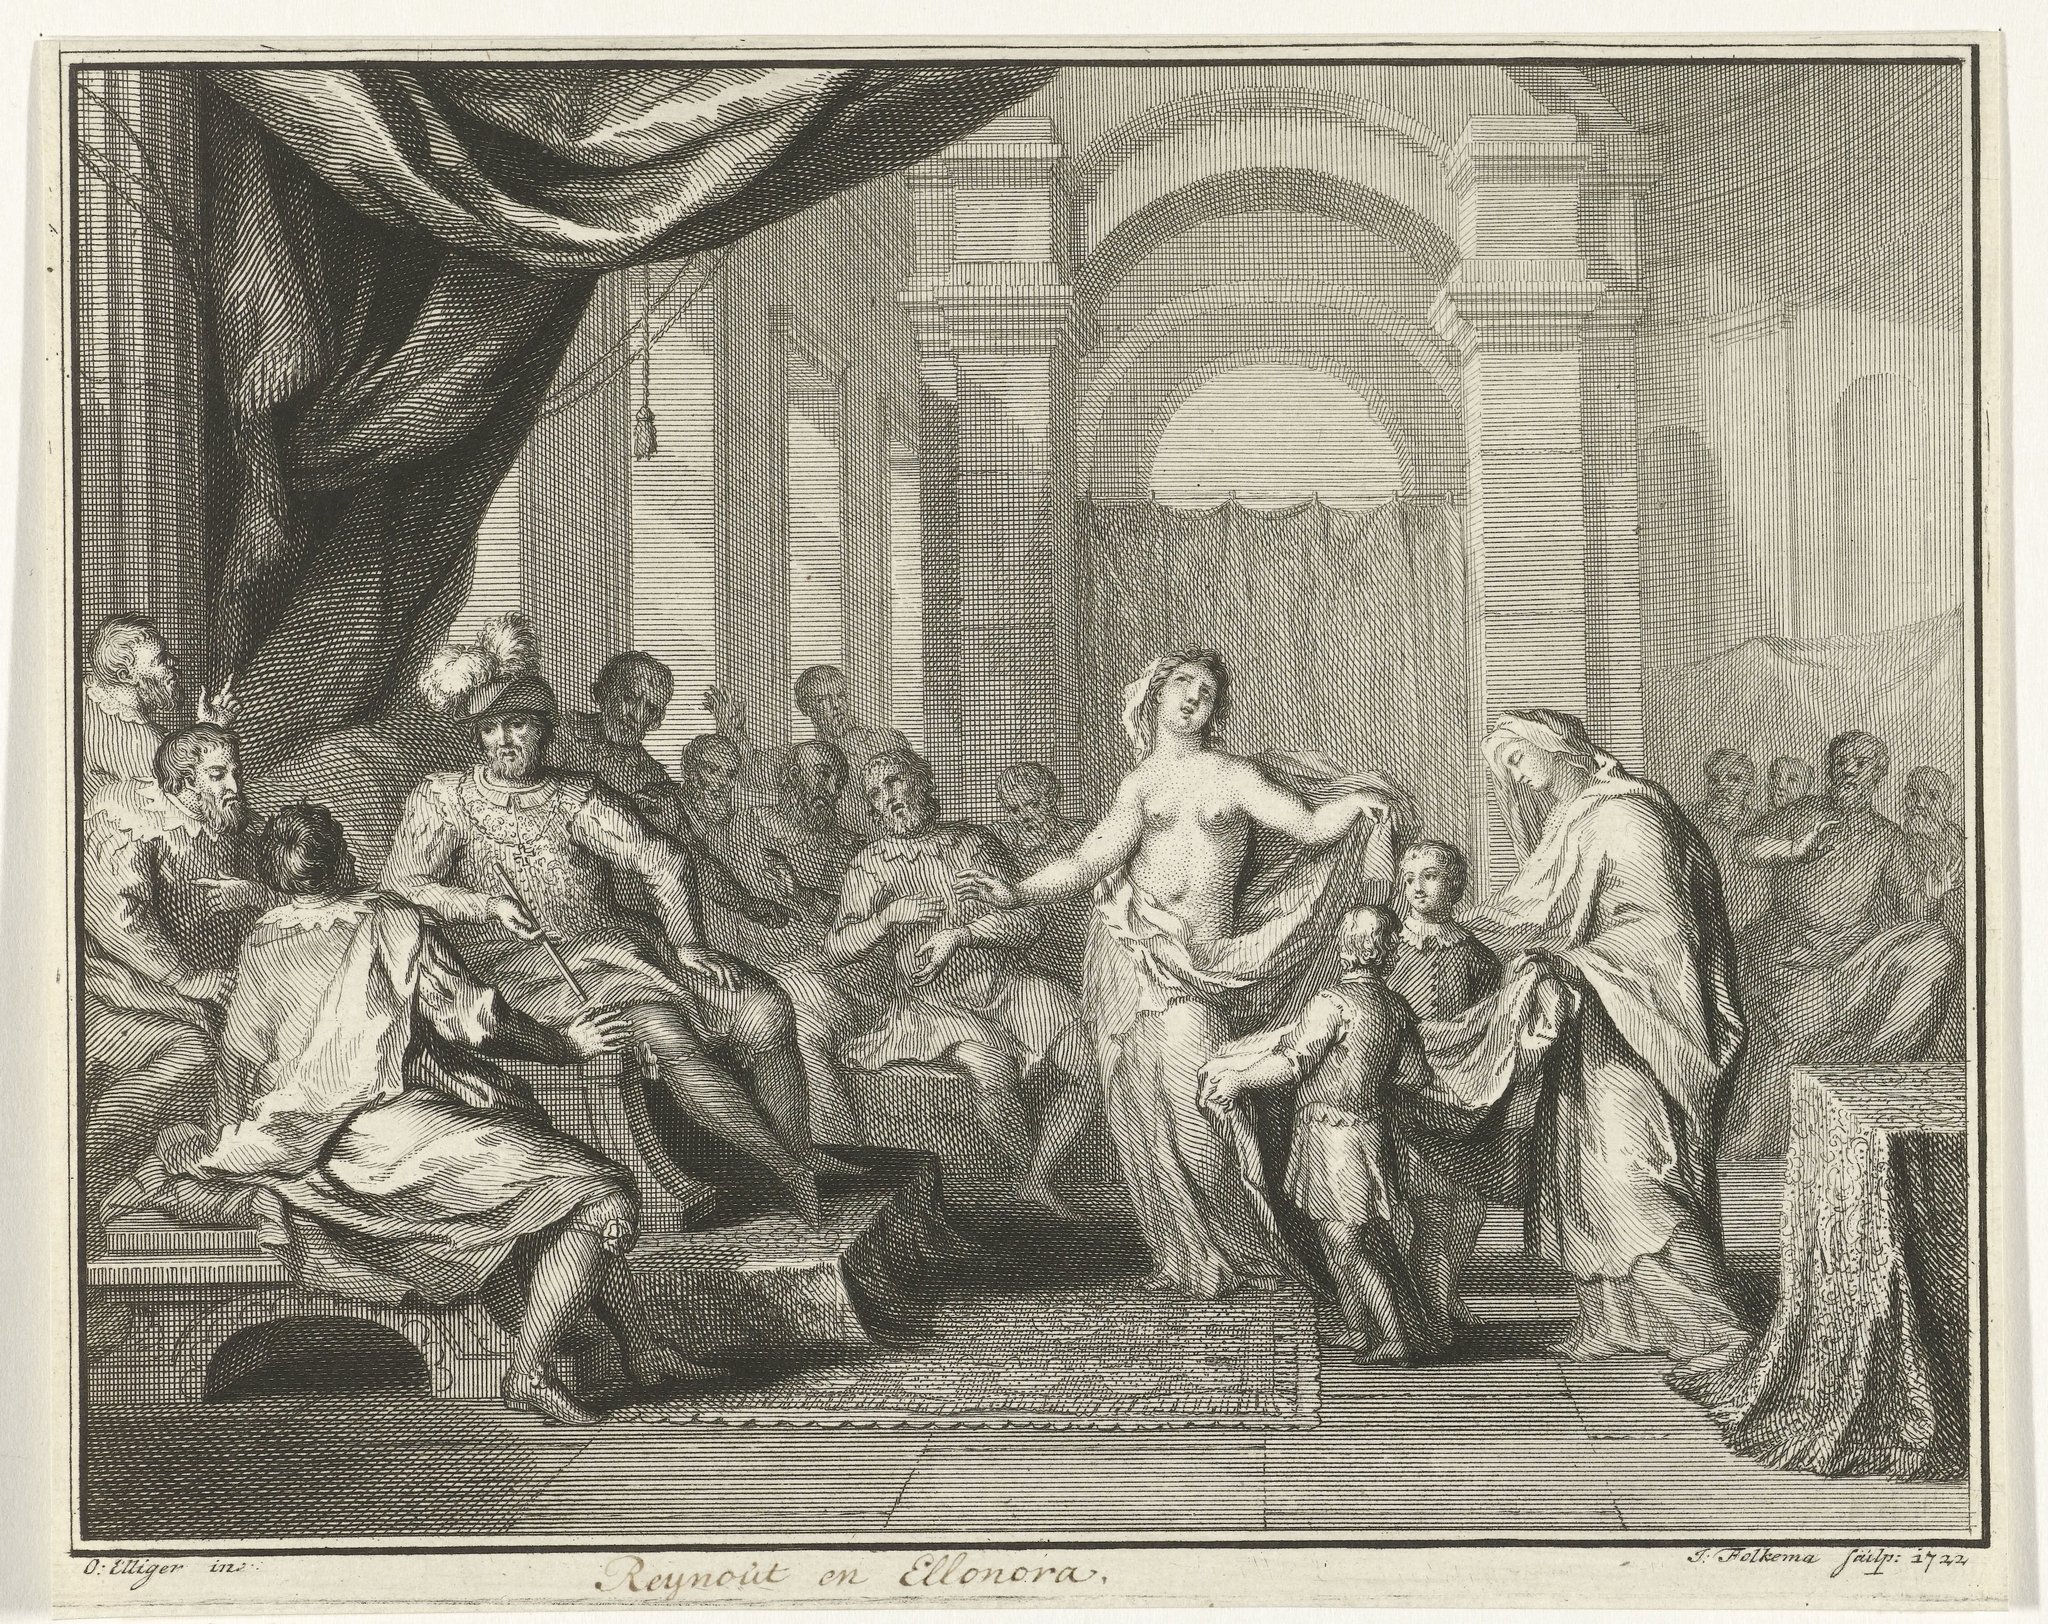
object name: print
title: Eleonora van Engeland danst met onblootte borsten op een feest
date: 1722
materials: paper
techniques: etching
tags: deventer, woman dancing alone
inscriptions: collector's mark: Lugt 240, inscription: ‘Reynoût en Ellonora’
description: Reinoud van Gelre was getrouwd met Eleonora, de zus van koning Edward III van Engeland. Zij hadden geen goed huwelijk en Reinoud verspreidde het gerucht dat Eleonora melaats was. Eleonora verscheen op een feest van Reinoud op de Barbarossa-burcht en ontblootte haar borsten in het bijzijn van alle gasten. Hiermee wist ze de woorden van haar man te logenstraffen. De voorstelling toont de dansende Eleonora in een vertrek dat gevuld is met mannelijke gasten.